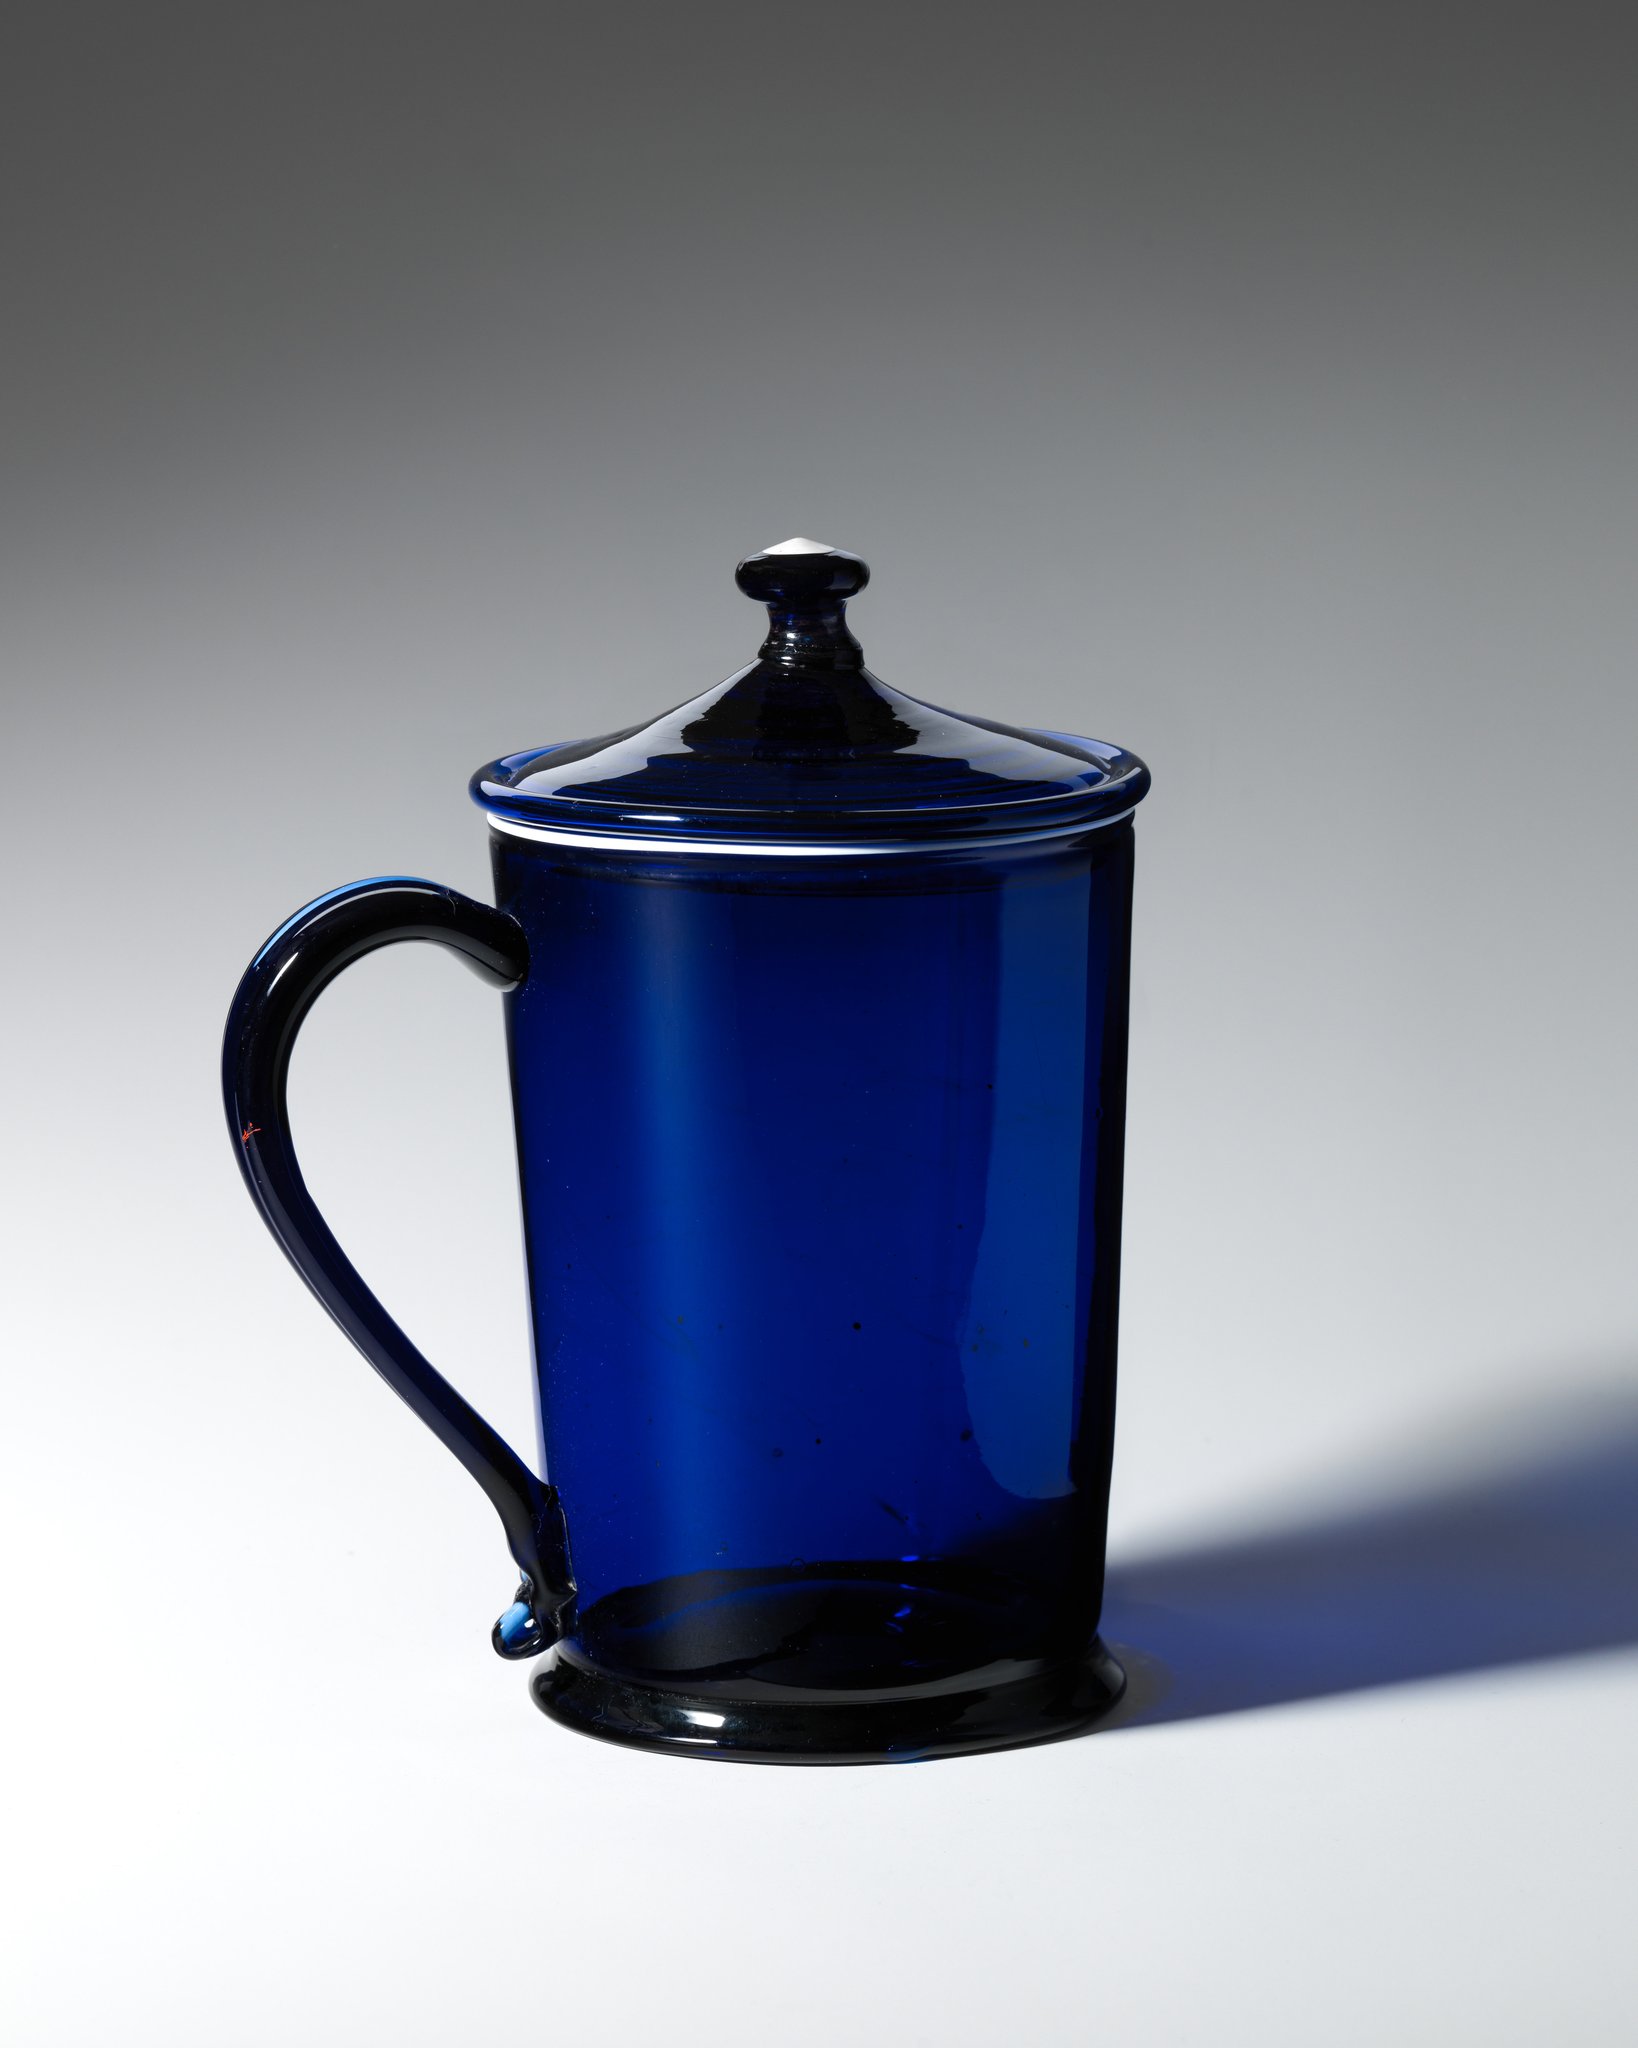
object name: tankard with cover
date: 1767-1800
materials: glass